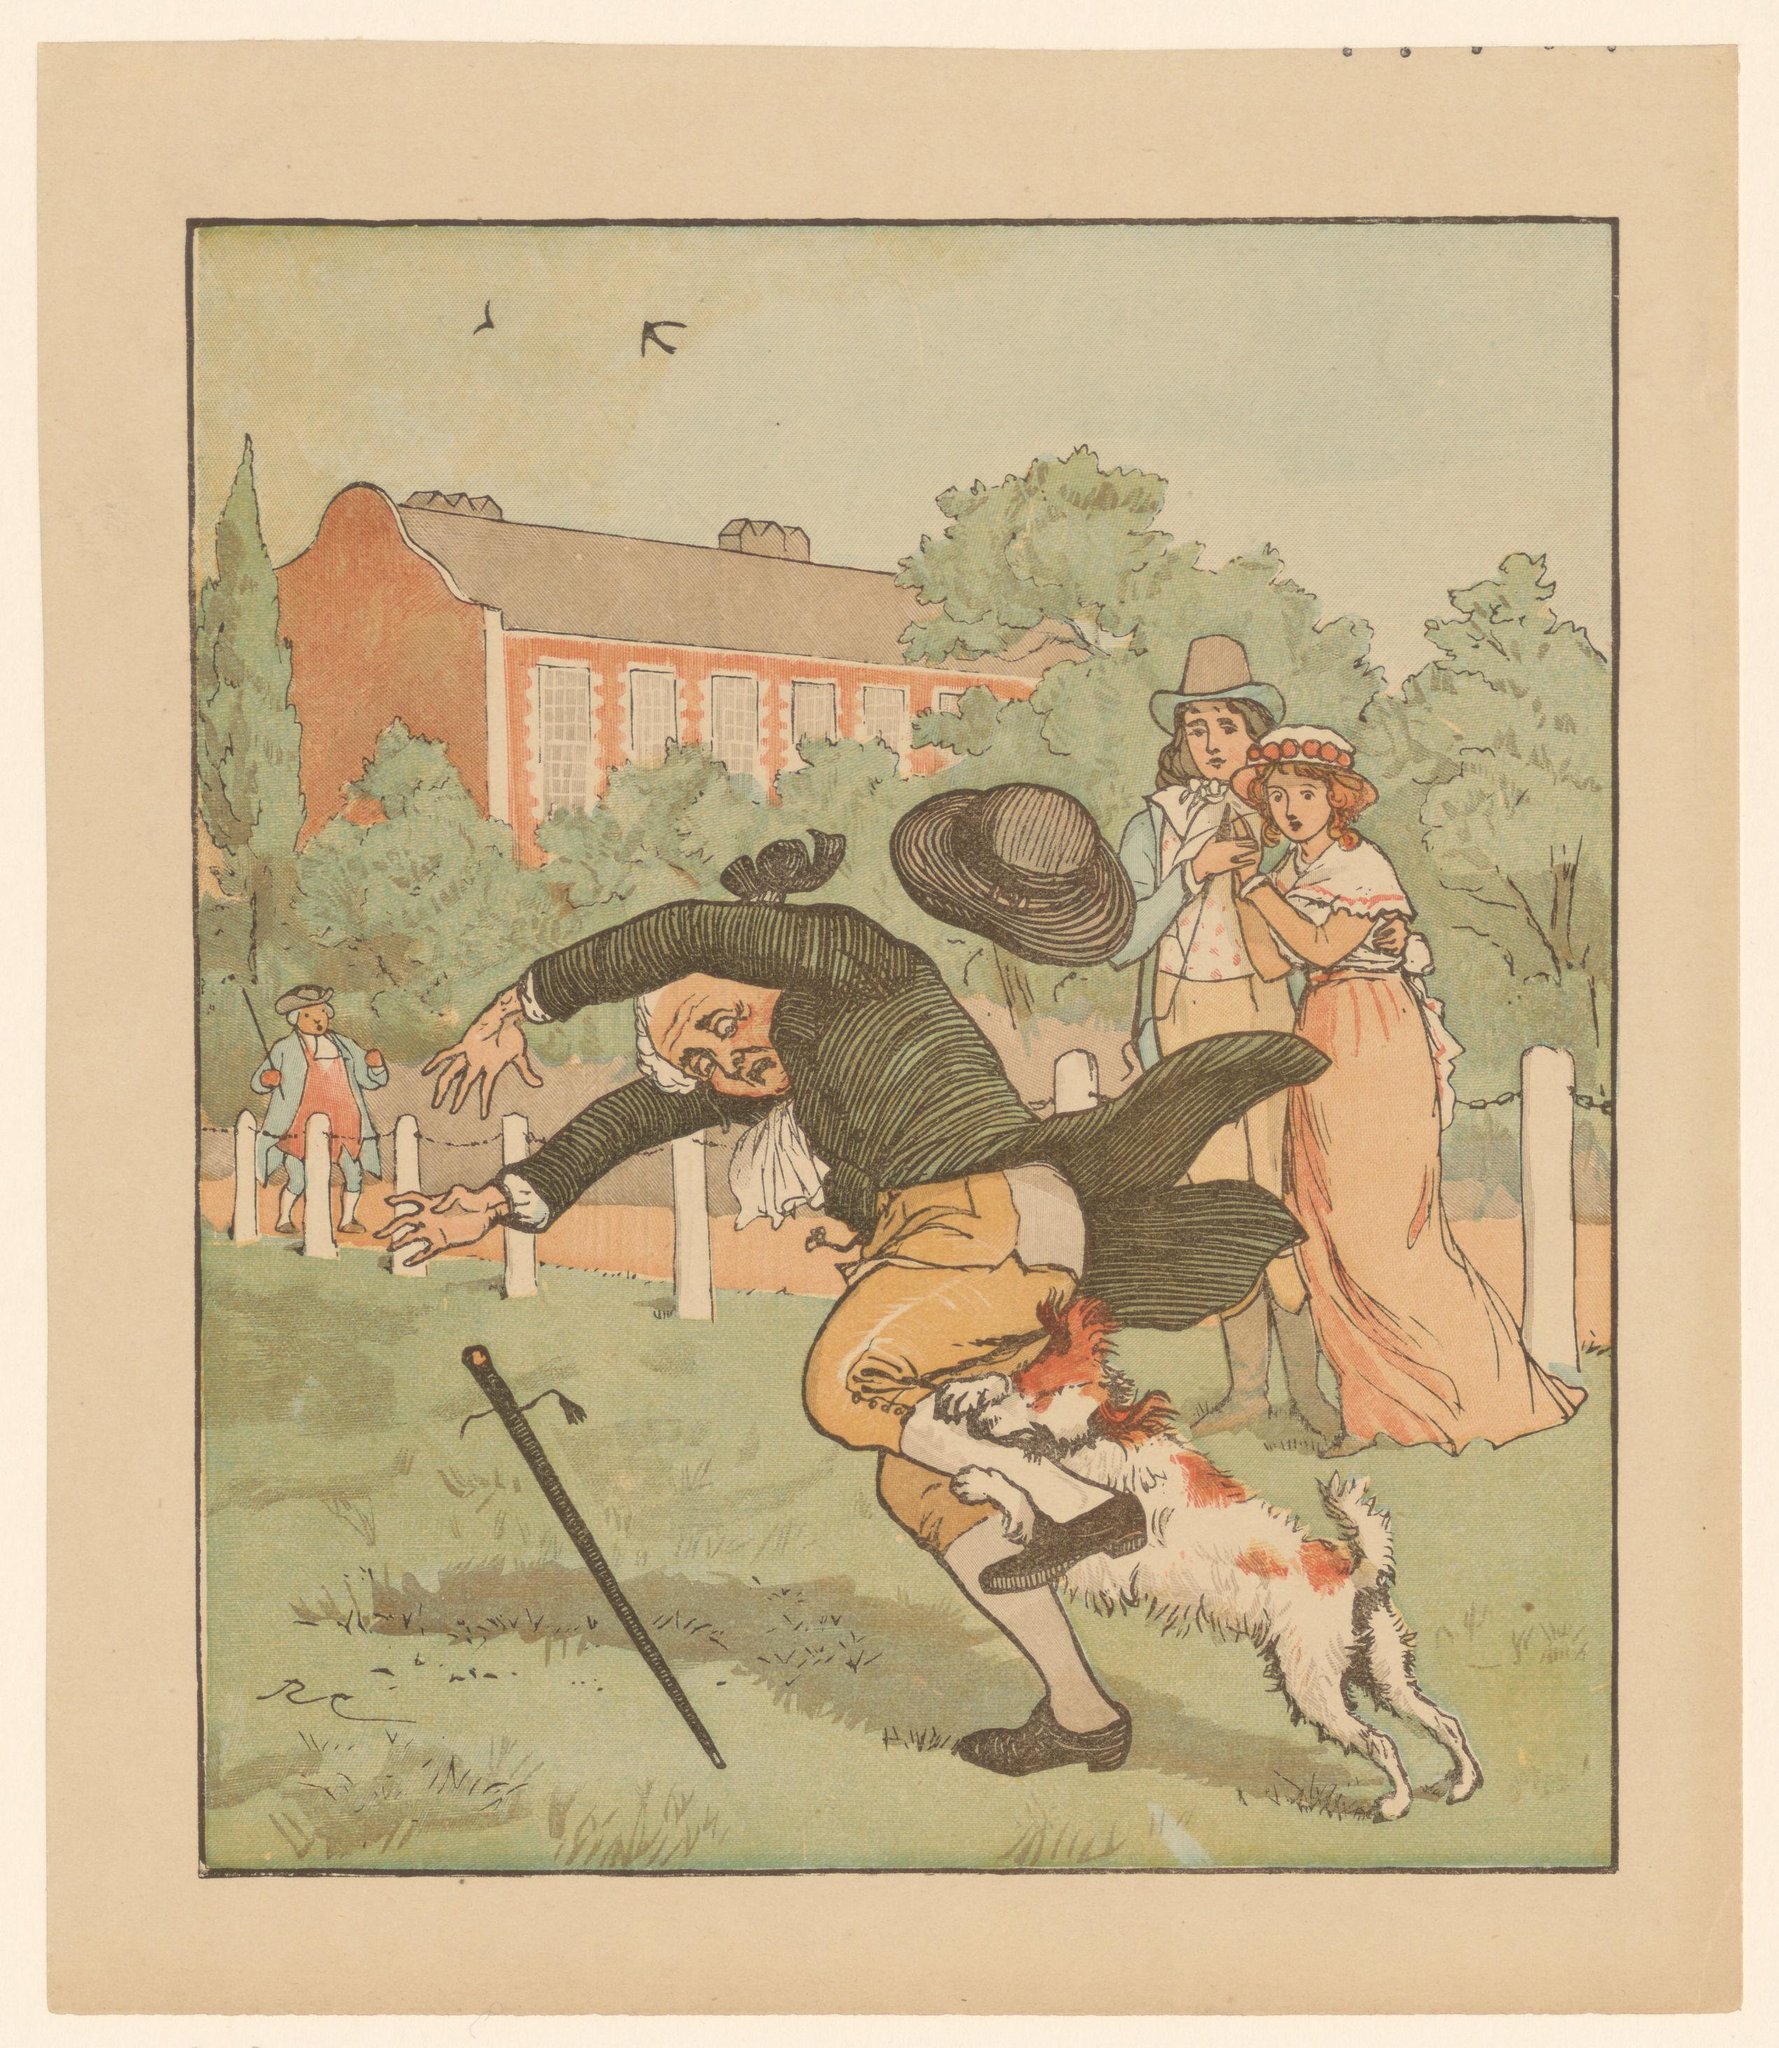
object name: print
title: Kleine hond bijt voorovervallende man in zijn onderbeen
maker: randolph caldecott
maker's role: painter, print maker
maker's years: 1846-1886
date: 1879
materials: paper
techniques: woodcut, letterpress printing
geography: london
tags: falling, dog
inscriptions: collector's mark: Lugt 2228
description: Prent uit: Goldsmith, Oliver. An Elegy on the Death of a Mad Dog. Londen: George Routledge & Sons, 1879.